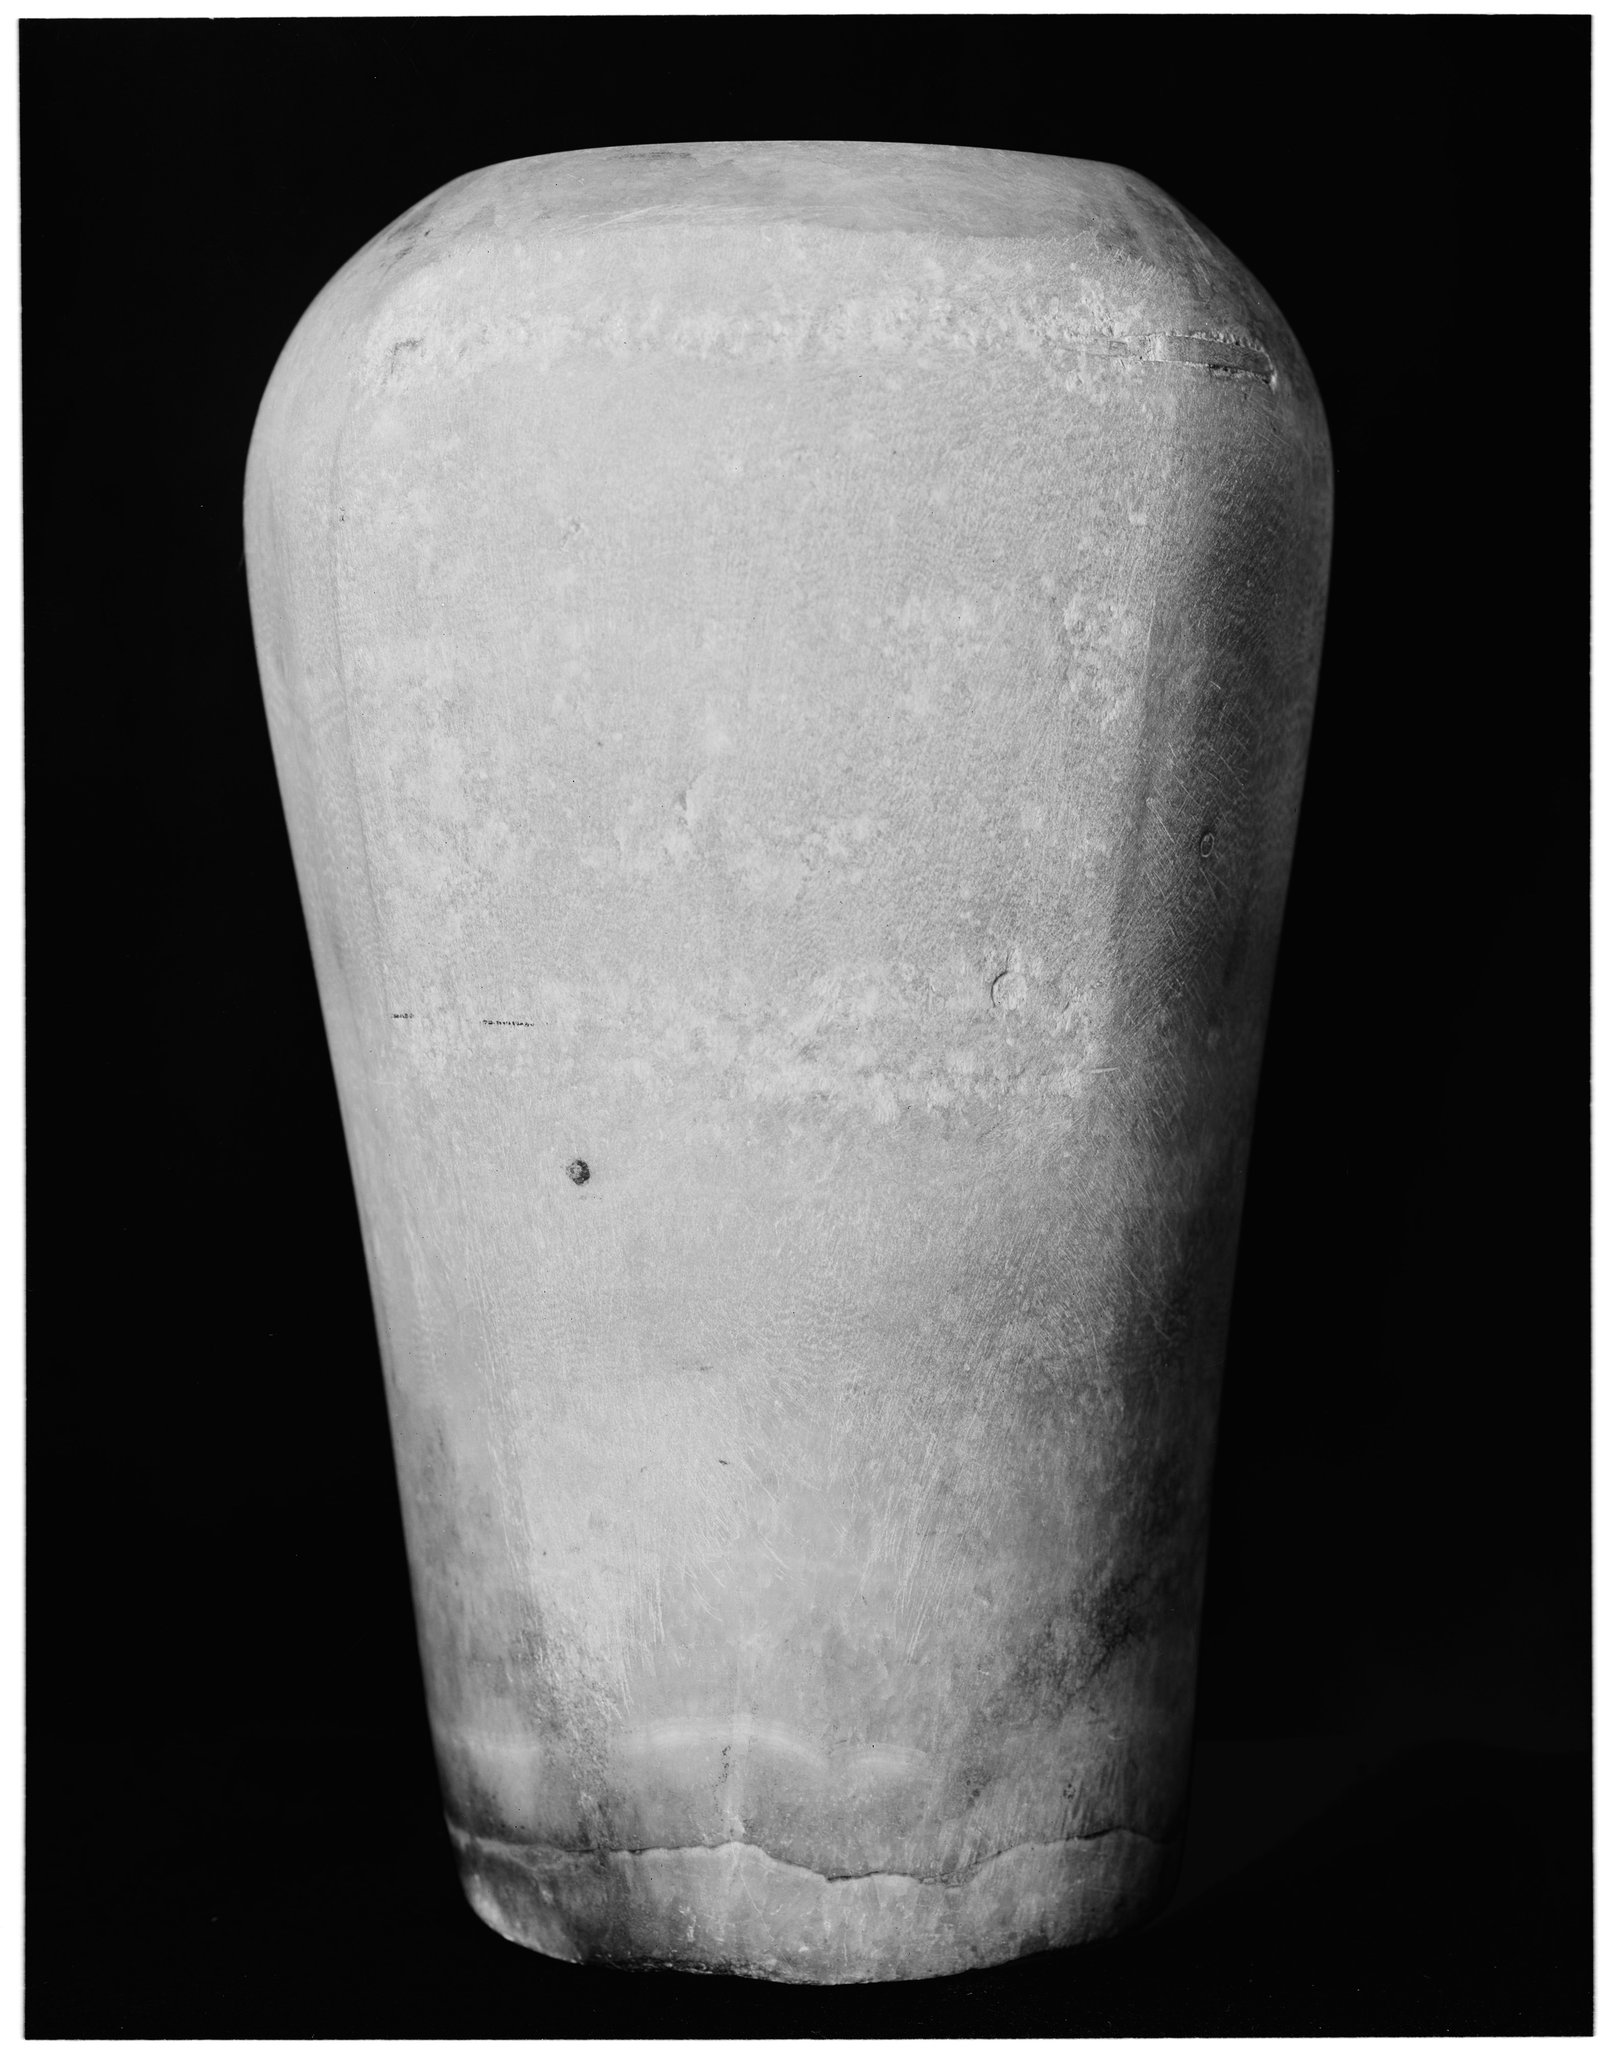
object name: canopic jar, kiya lid 30. 8. 54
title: Canopic Jar (with lid 30.8.54)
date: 1349-1336 BCE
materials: stone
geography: egypt